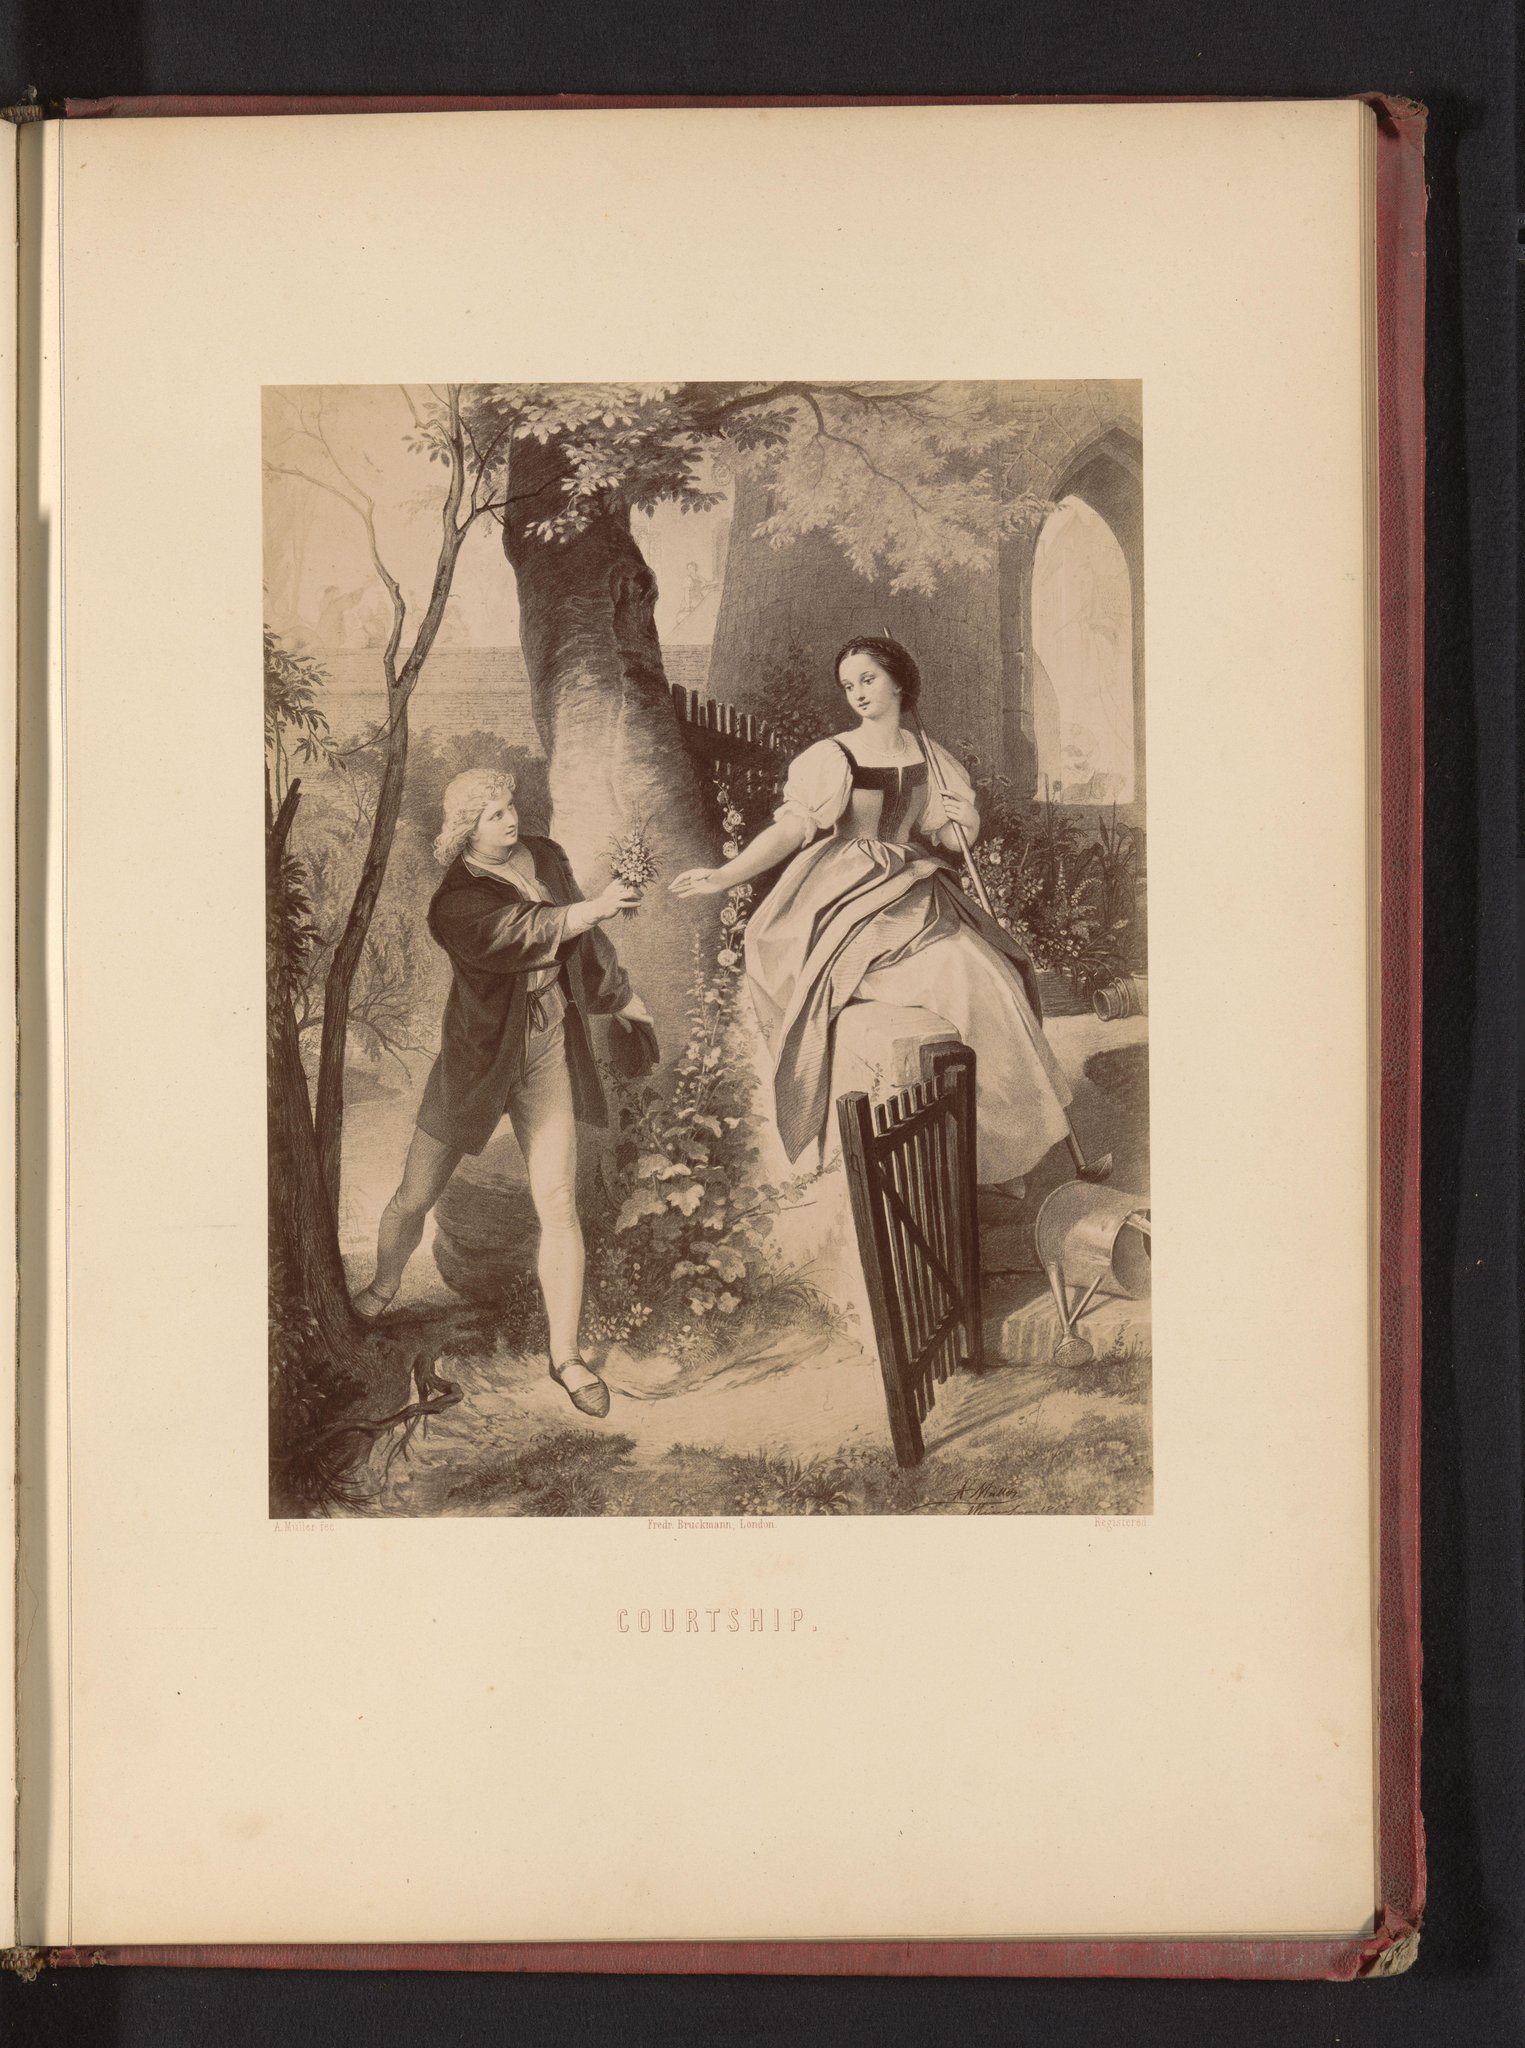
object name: reproduction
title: Fotoreproductie van een tekening van een scene uit Das Lied von der Glocke van Friedrich Schiller, door A. Müller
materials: photographic support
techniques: albumen print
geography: london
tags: presents offered to the beloved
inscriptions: inscription: ‘Registered.’